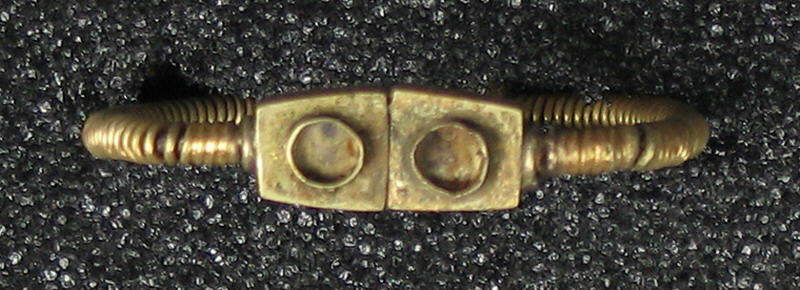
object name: toe ring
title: Toe Ring with Two Rectangular Bezels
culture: indonesian, east java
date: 901-1400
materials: gold